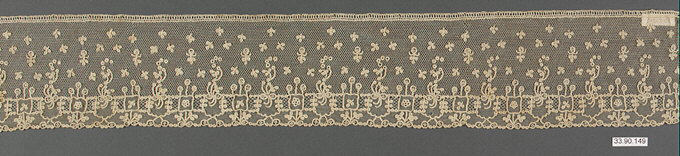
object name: edging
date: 1767-1800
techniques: lace